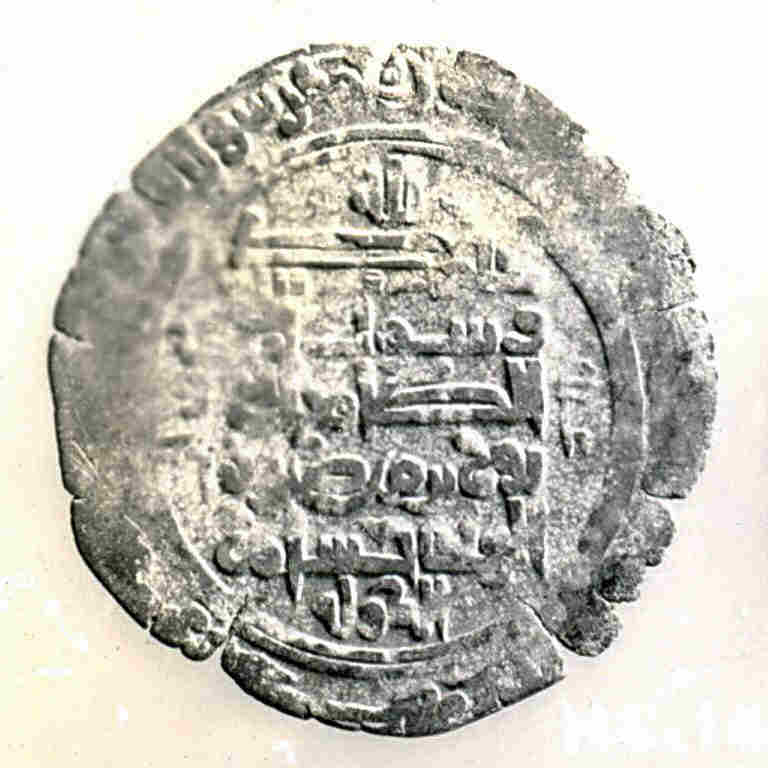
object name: coin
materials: silver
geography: iran